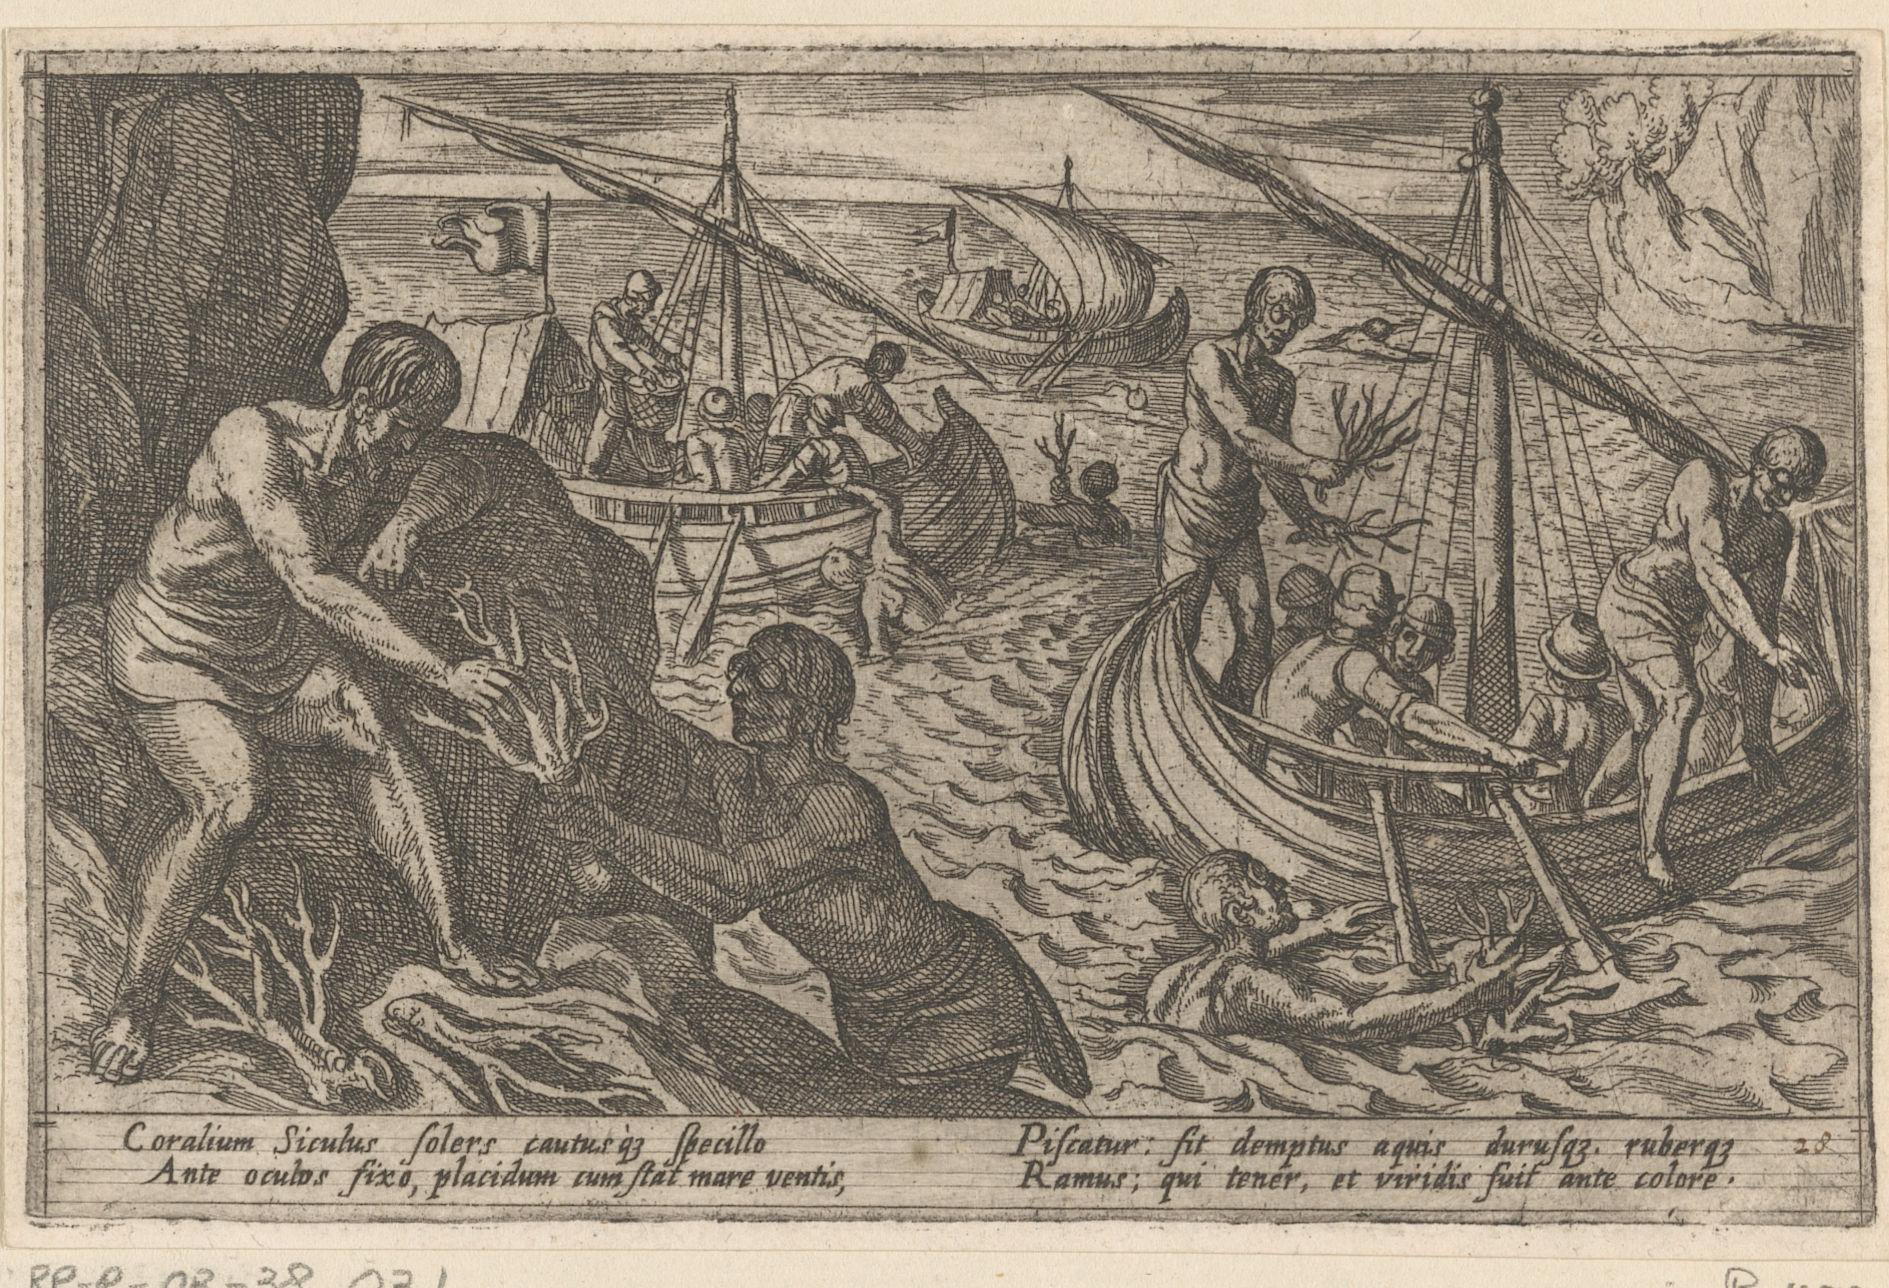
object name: print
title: Diverse jacht- en strijdscènes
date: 1602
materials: paper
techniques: etching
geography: italy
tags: coelenterata: coral, hunter, hunters hunting (n.b.: in 1988-1990 this notation denoted the concept of 43c11421 'hunters resting during the hunt'), pearl fishing, pearl diving; coral fishing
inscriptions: collector's mark: Lugt 240, number: ‘28’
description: Kustlandschap met Siciliaanse vissers, zwemmend en op boten, duikend naar koraal. De duikers dragen duikbrillen. Tekst in het Latijn in ondermarge.